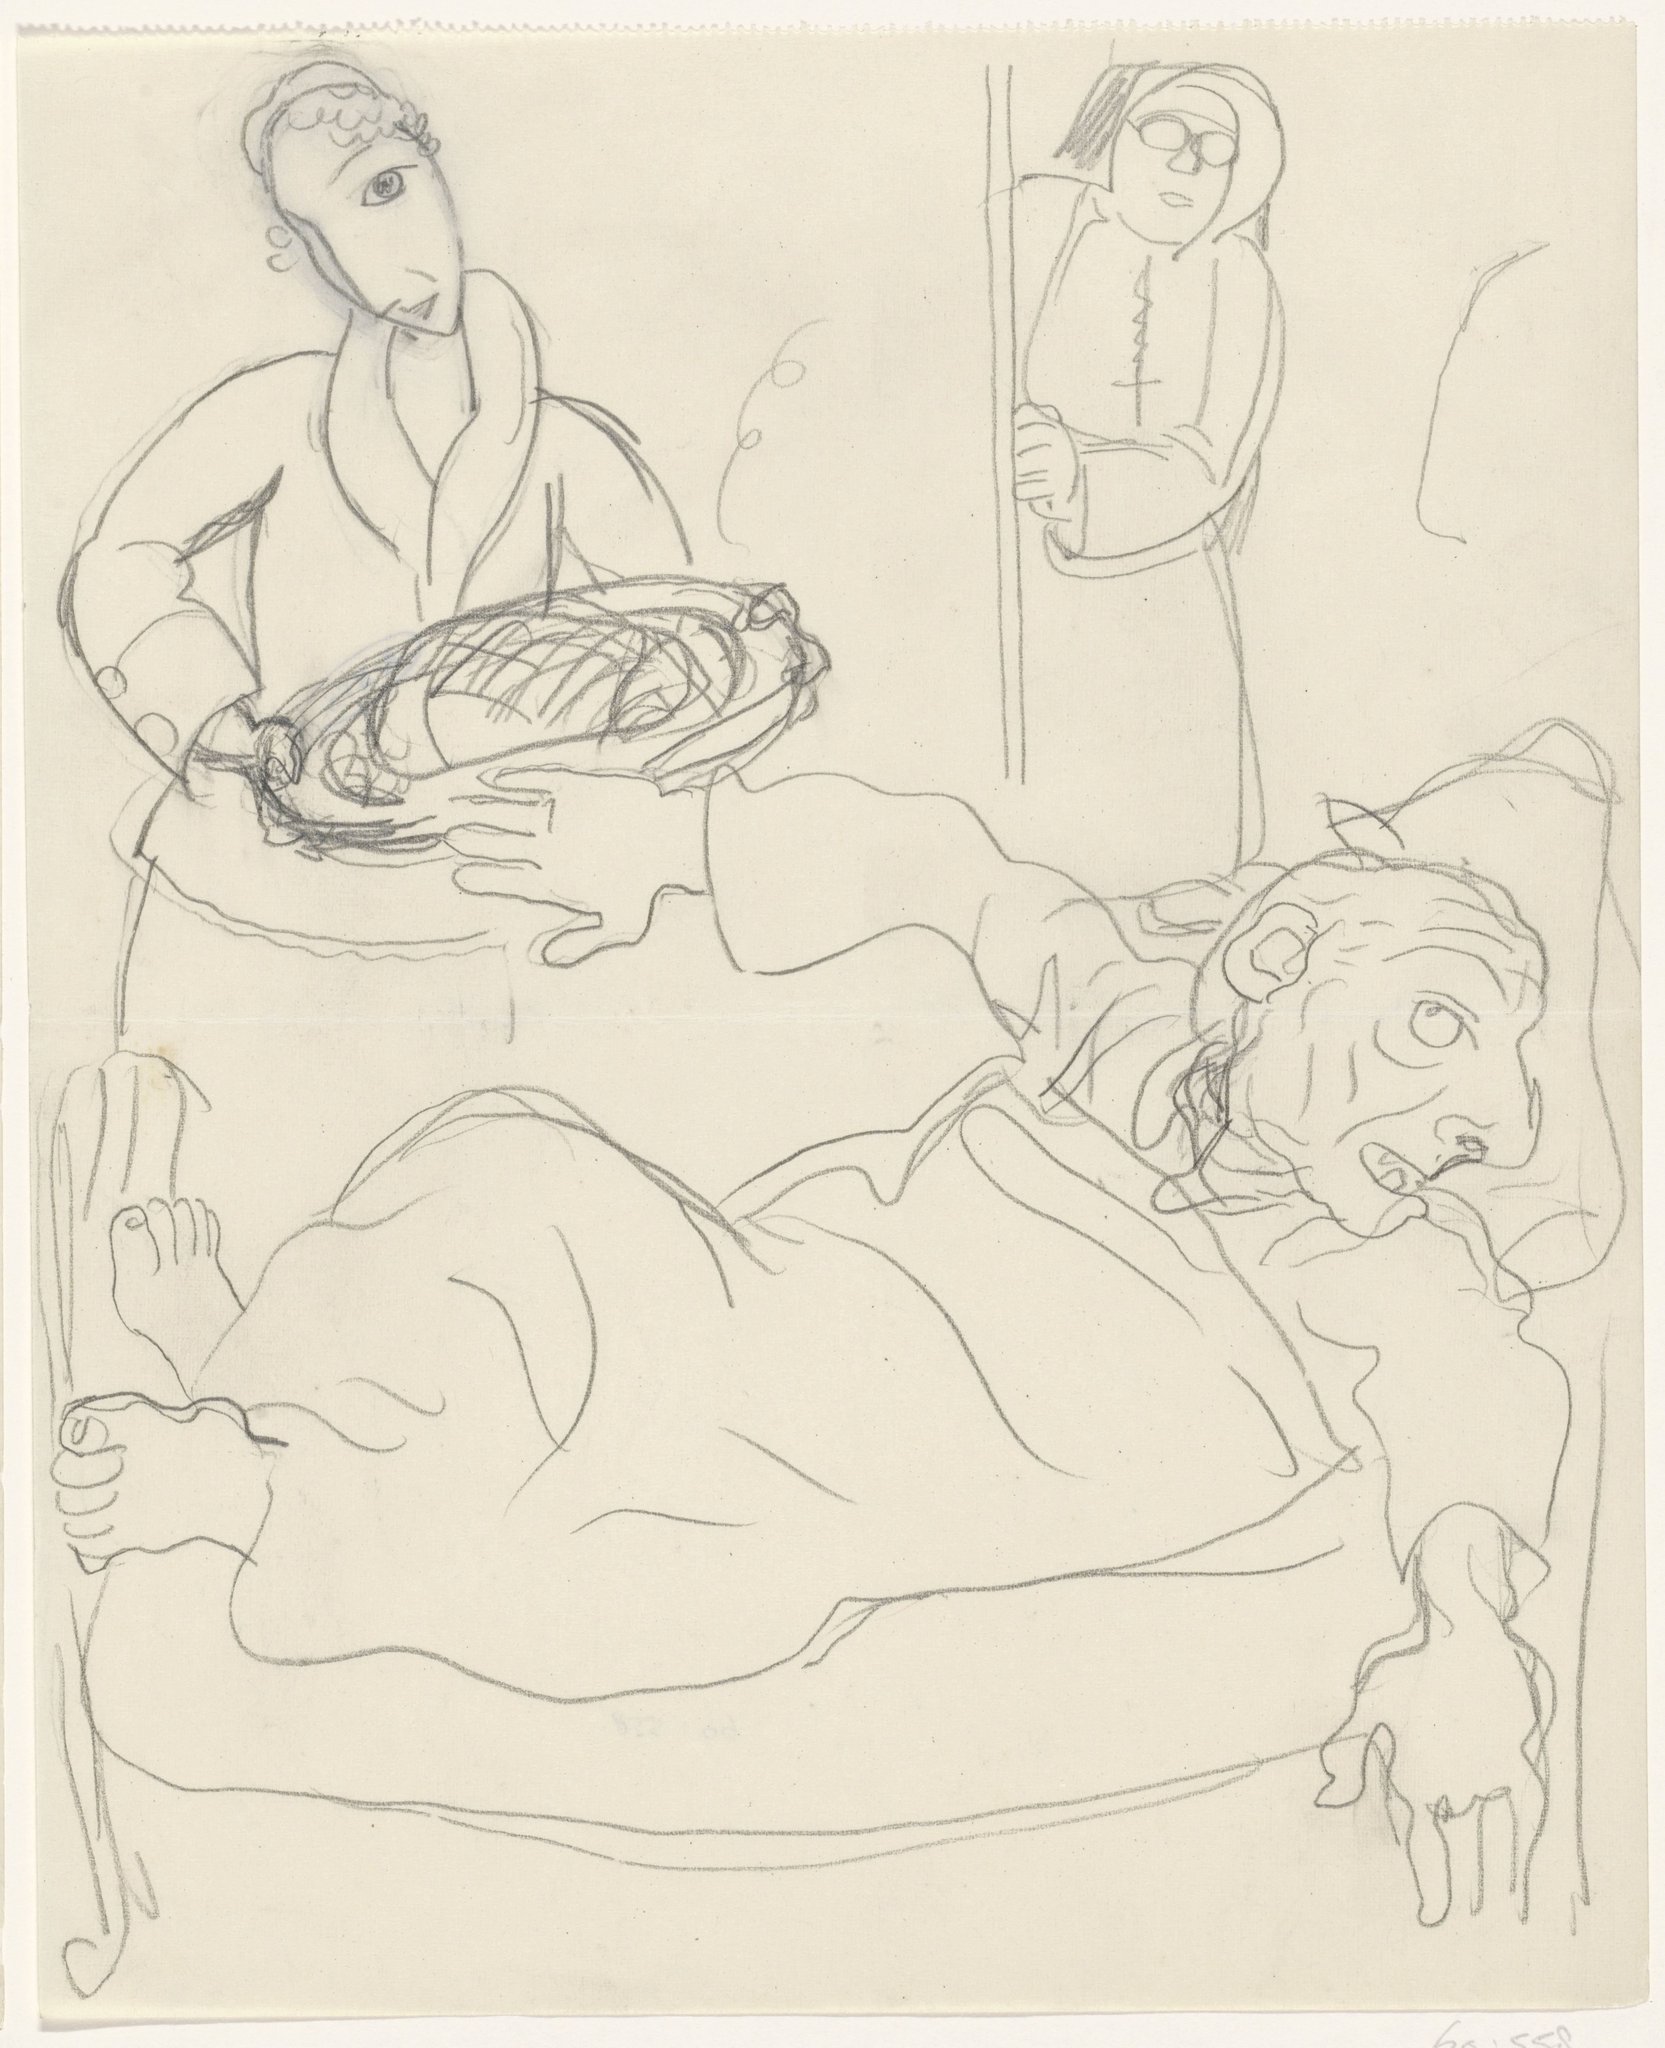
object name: drawing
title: Karikatuur van Leo Gestel op zijn ziekbed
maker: leo gestel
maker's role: draughtsman, print maker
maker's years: 1881-1941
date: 1911-1941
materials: paper, pencil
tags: draughtsman, leo gestel, sick-bed, historical persons, portrait, self-portrait of artist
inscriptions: collector's mark: Lugt 2228